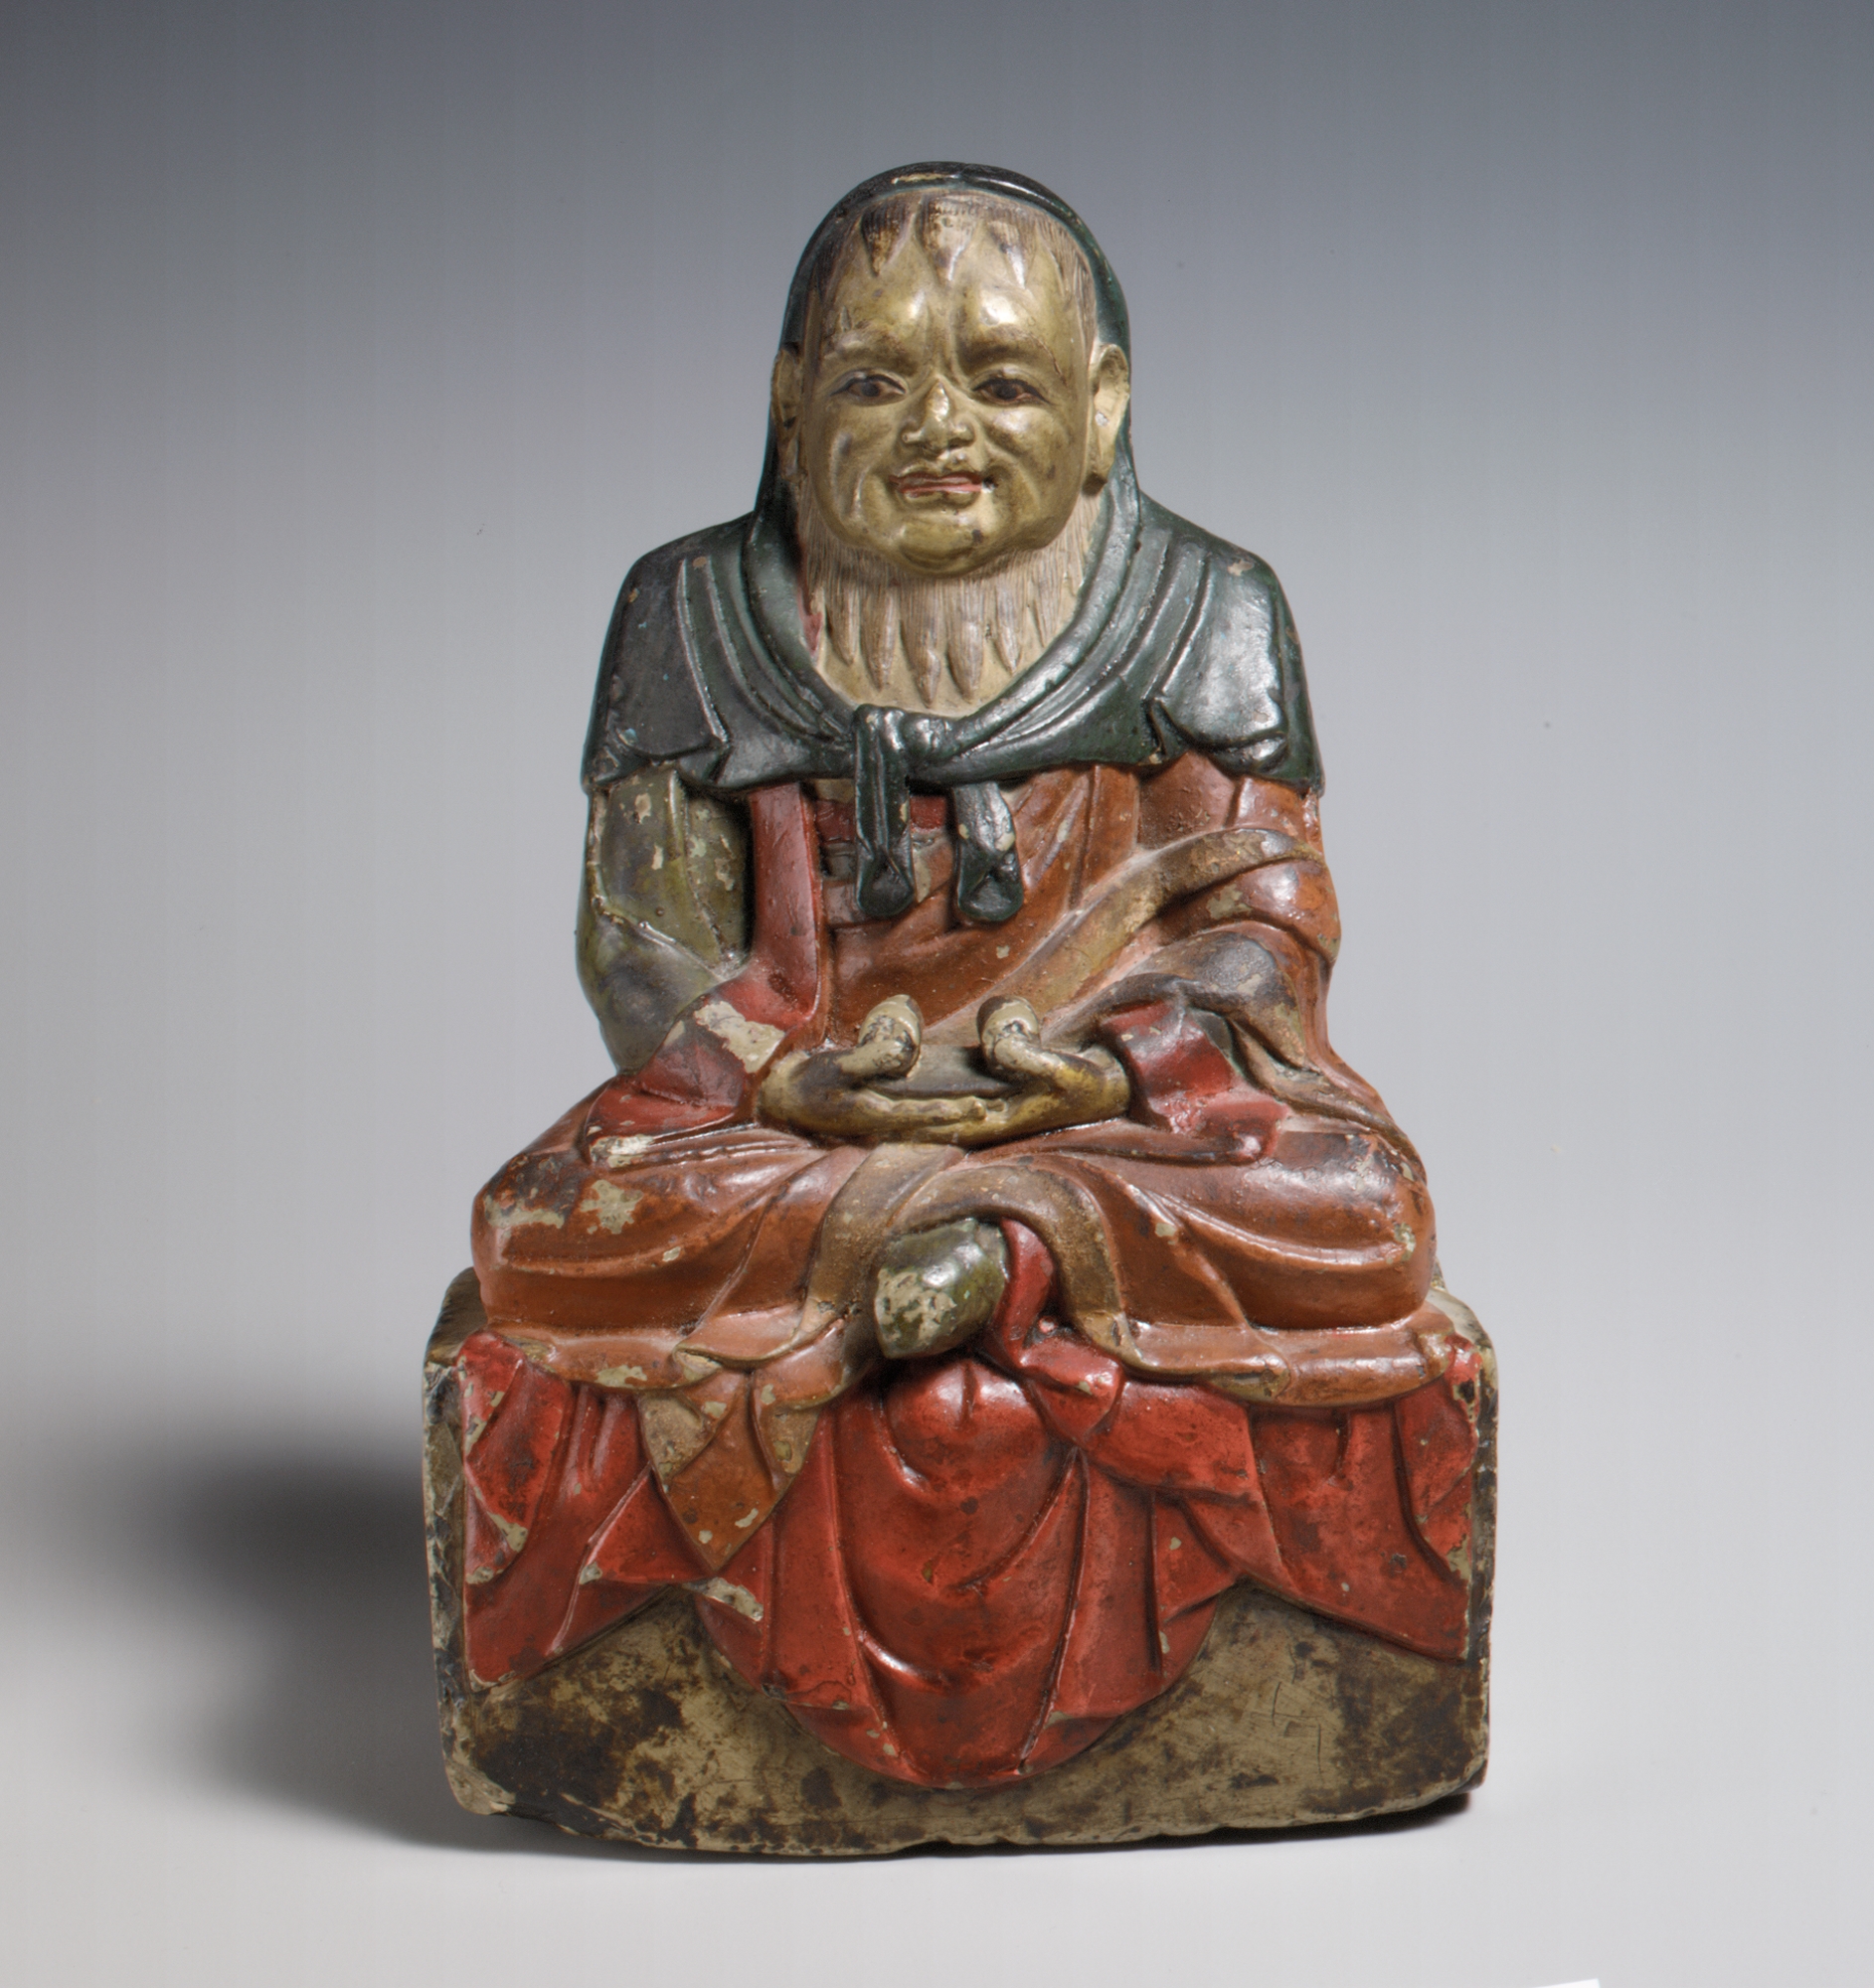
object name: figure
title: An Arhat, a Buddhist Saint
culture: tibetan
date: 1301-1400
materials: stone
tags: men,buddhism,saints